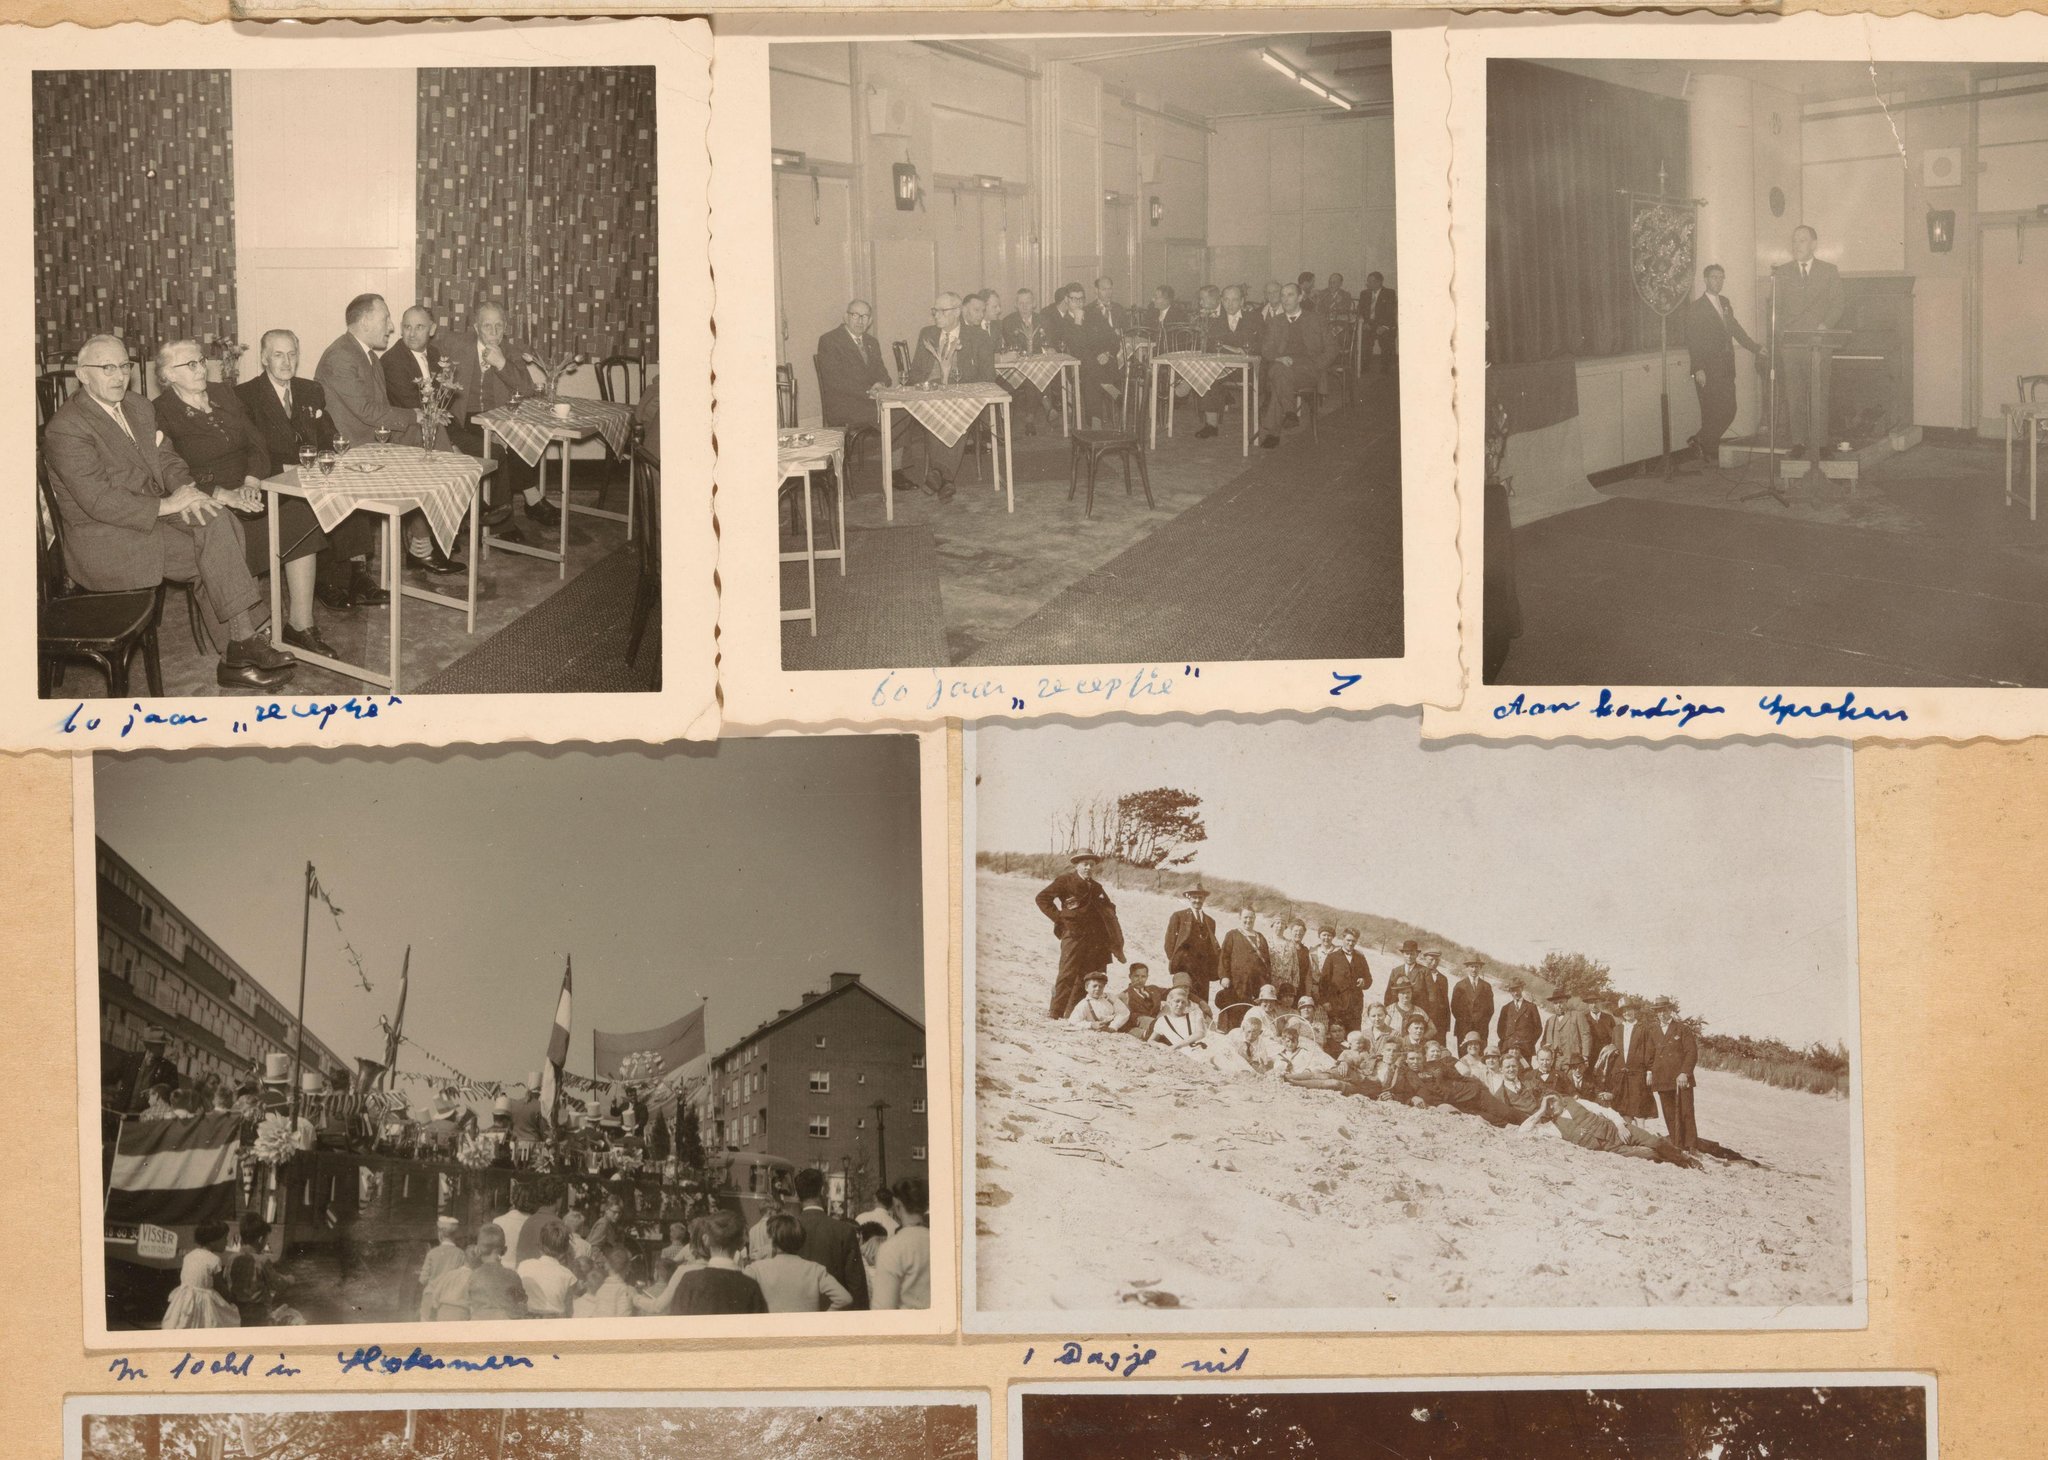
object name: photograph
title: 1 Dagje uit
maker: Anonymous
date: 1930-1950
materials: cardboard, photographic support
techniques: gelatin silver print